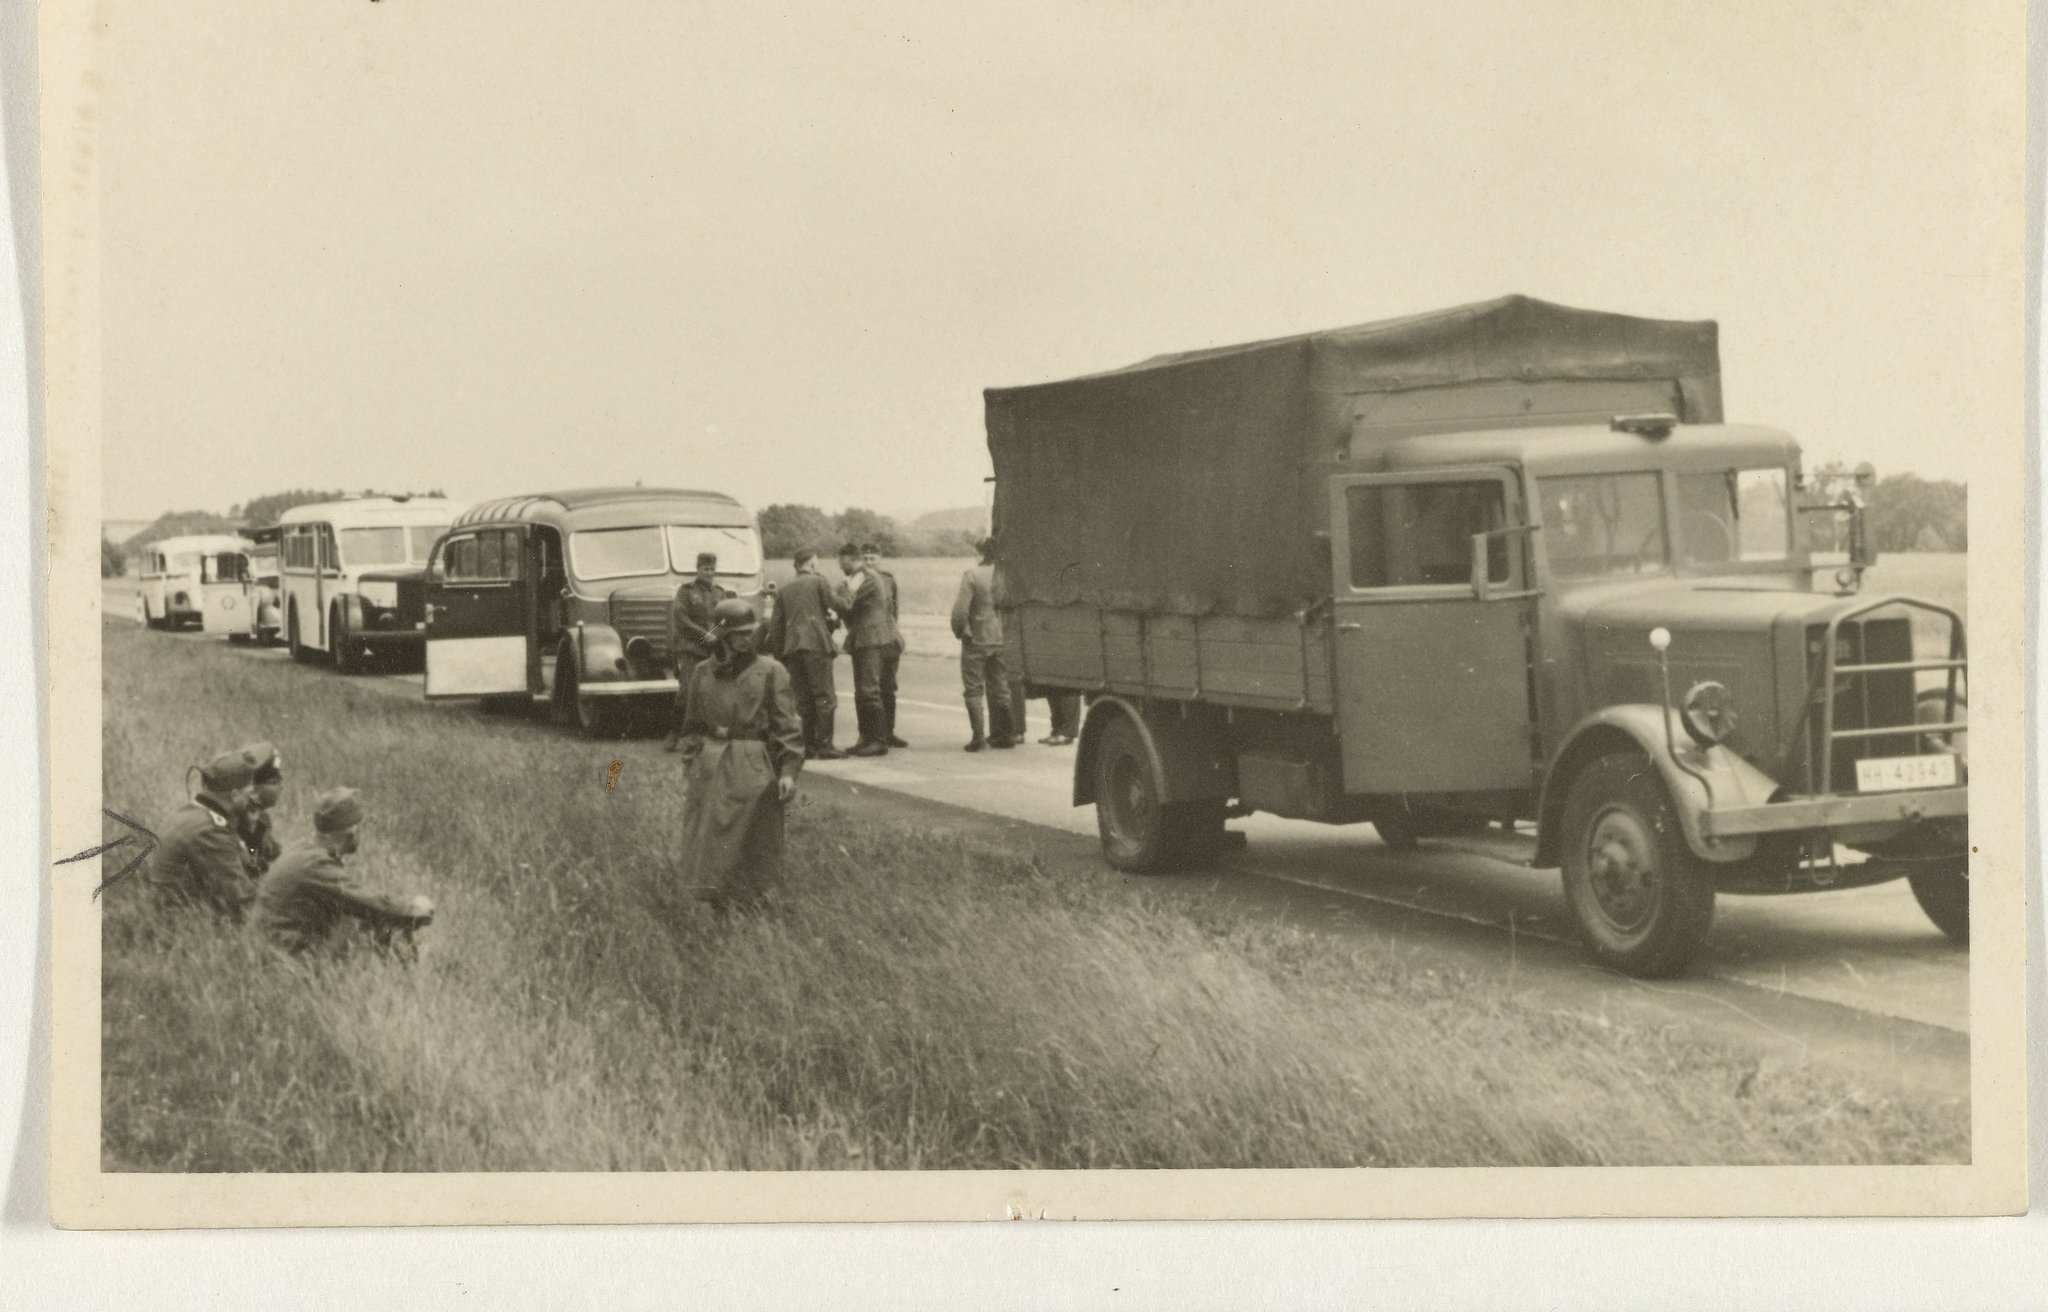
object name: photograph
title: Duitse militairen bij een vrachtauto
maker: Anonymous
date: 1940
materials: photographic support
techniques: gelatin silver print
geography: netherlands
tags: troop movements, transportation, occupation ~ war, netherlands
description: Duitse militairen staan op een weg bij een vrachtauto en twee bussen. Drie militairen zitten in het gras. Achterop staat: Die beiden Feldwebel am 16.6.40.